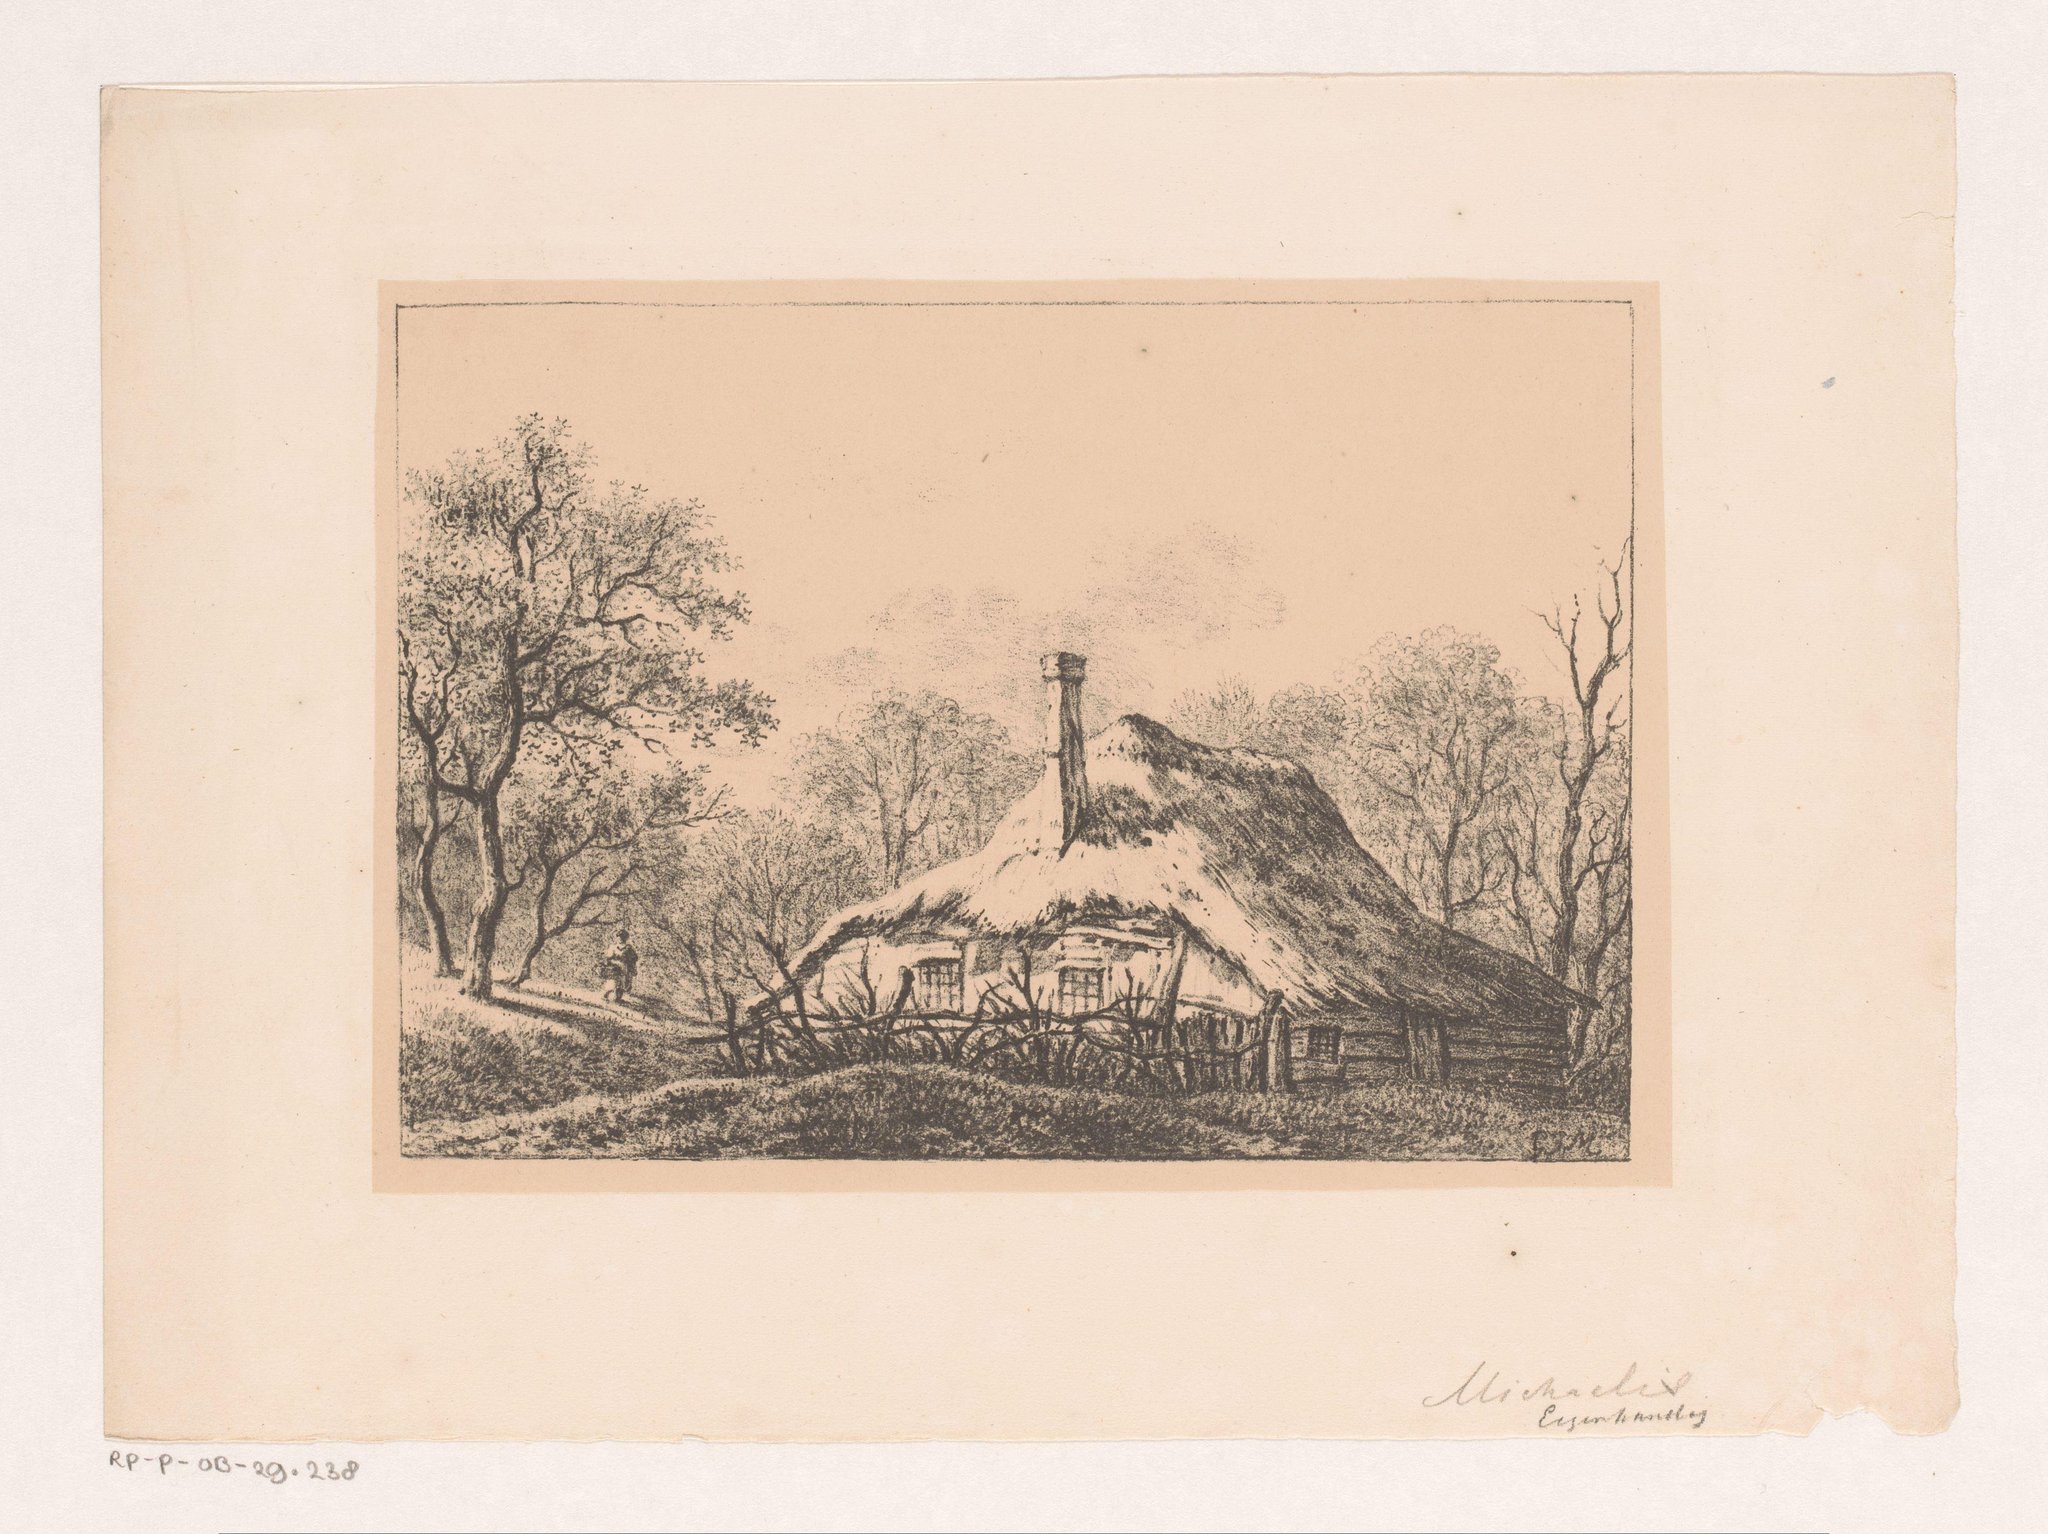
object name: print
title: Boerderij in het bos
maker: gerrit jan michaëlis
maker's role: draughtsman, painter, print maker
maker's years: 1775-1857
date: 1809-1857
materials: paper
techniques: lithograph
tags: forest, wood, farm or solitary house in landscape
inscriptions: inscription: ‘Michaelis / Eigenhandig’, collector's mark: Lugt 2228